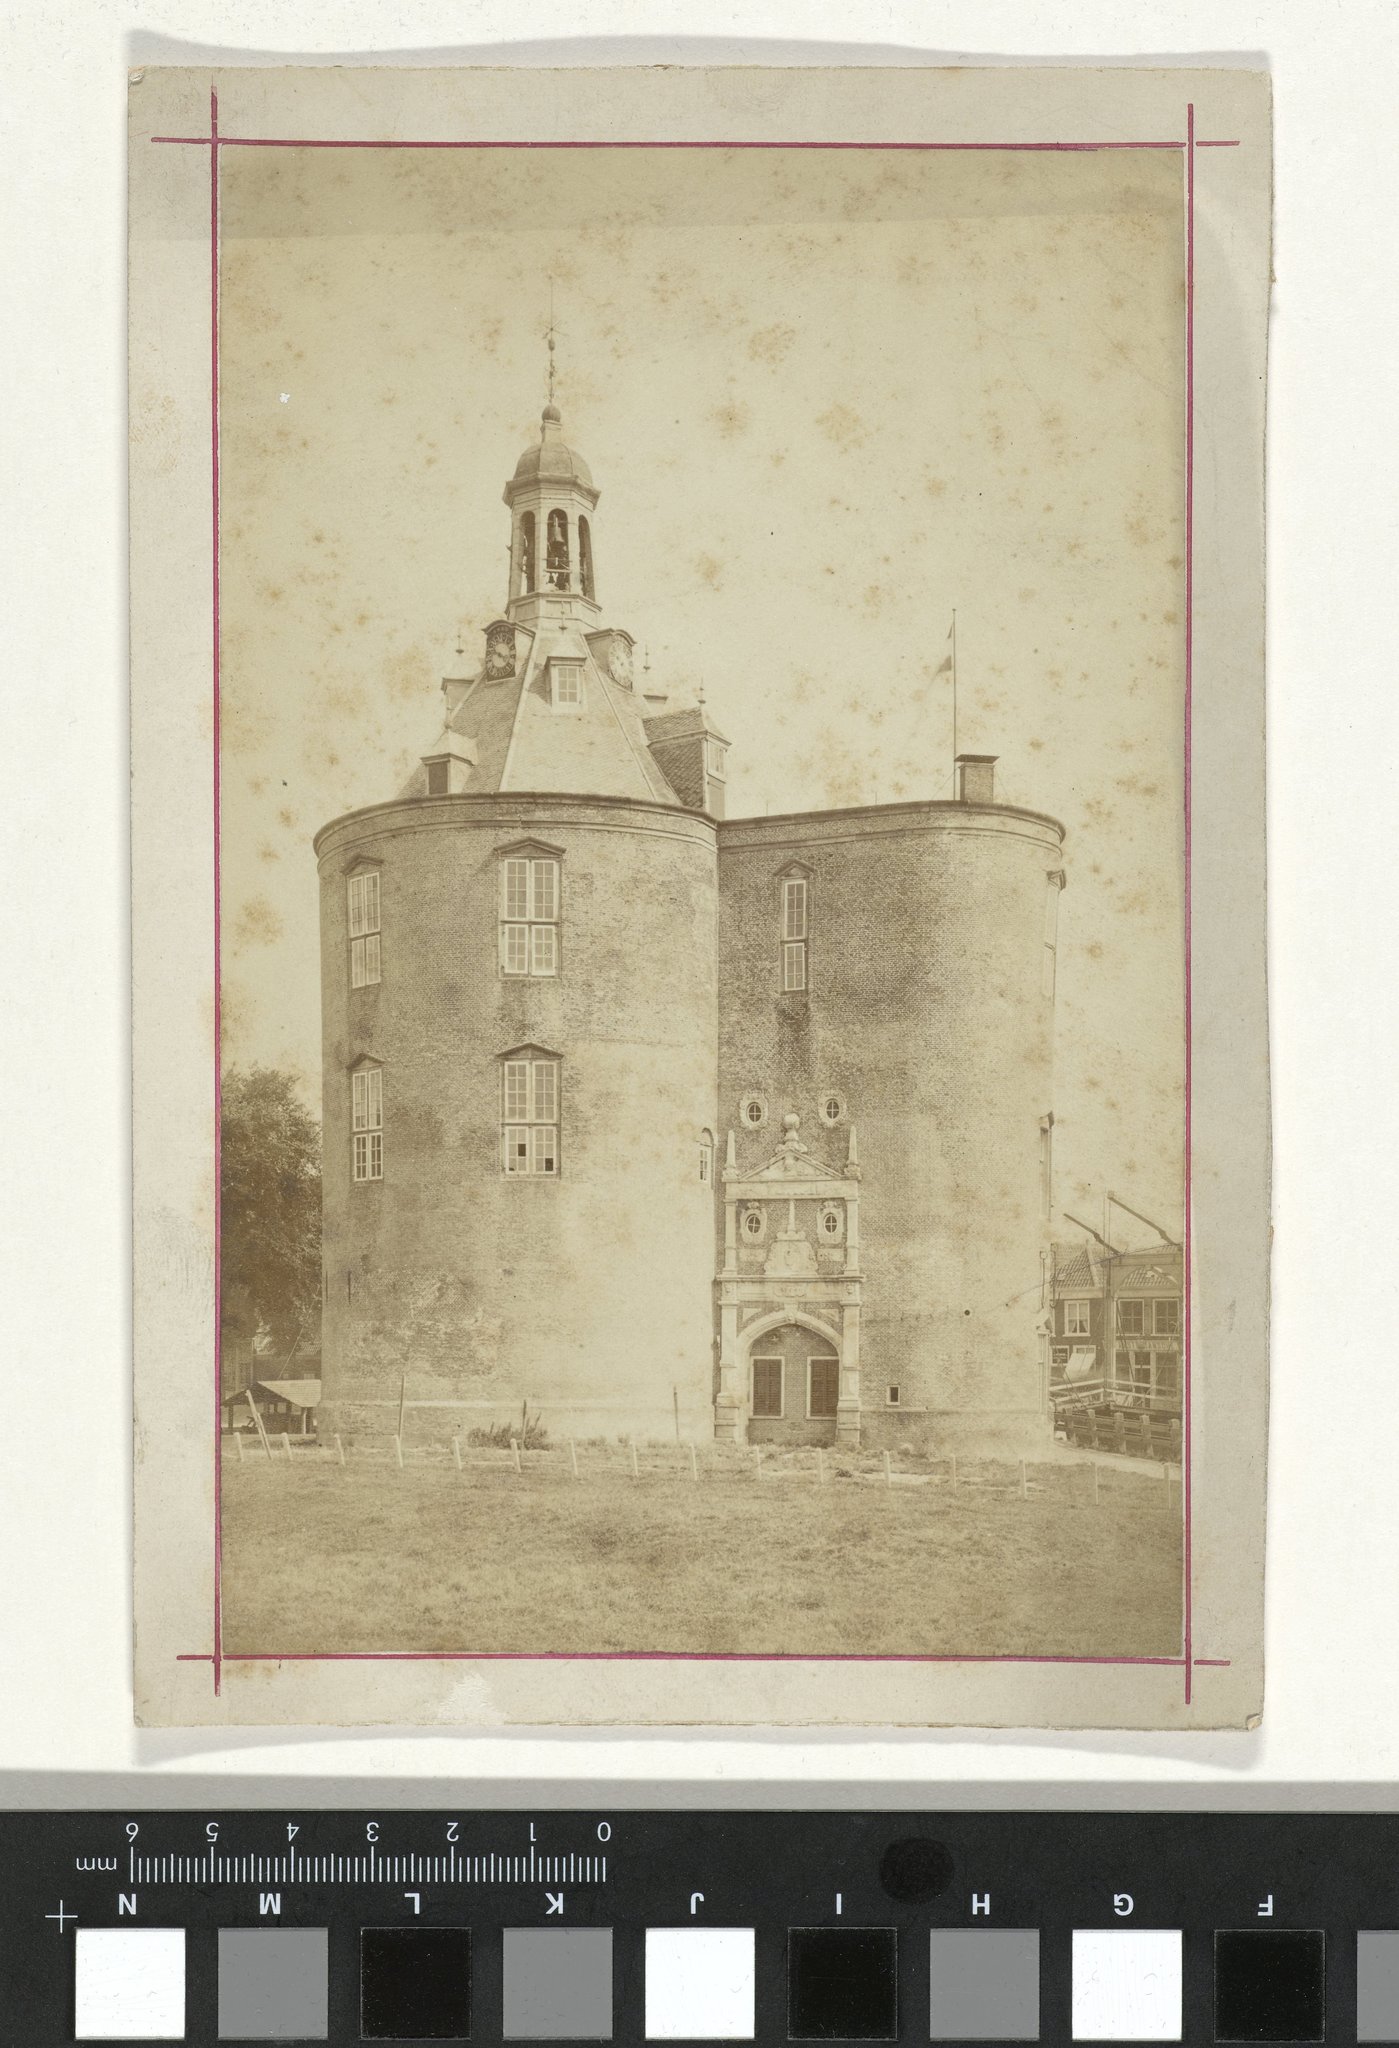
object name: photograph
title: Enkhuizen, porte de vache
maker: Anonymous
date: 1880-1915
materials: cardboard, paper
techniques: albumen print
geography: enkhuizen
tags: city-gate